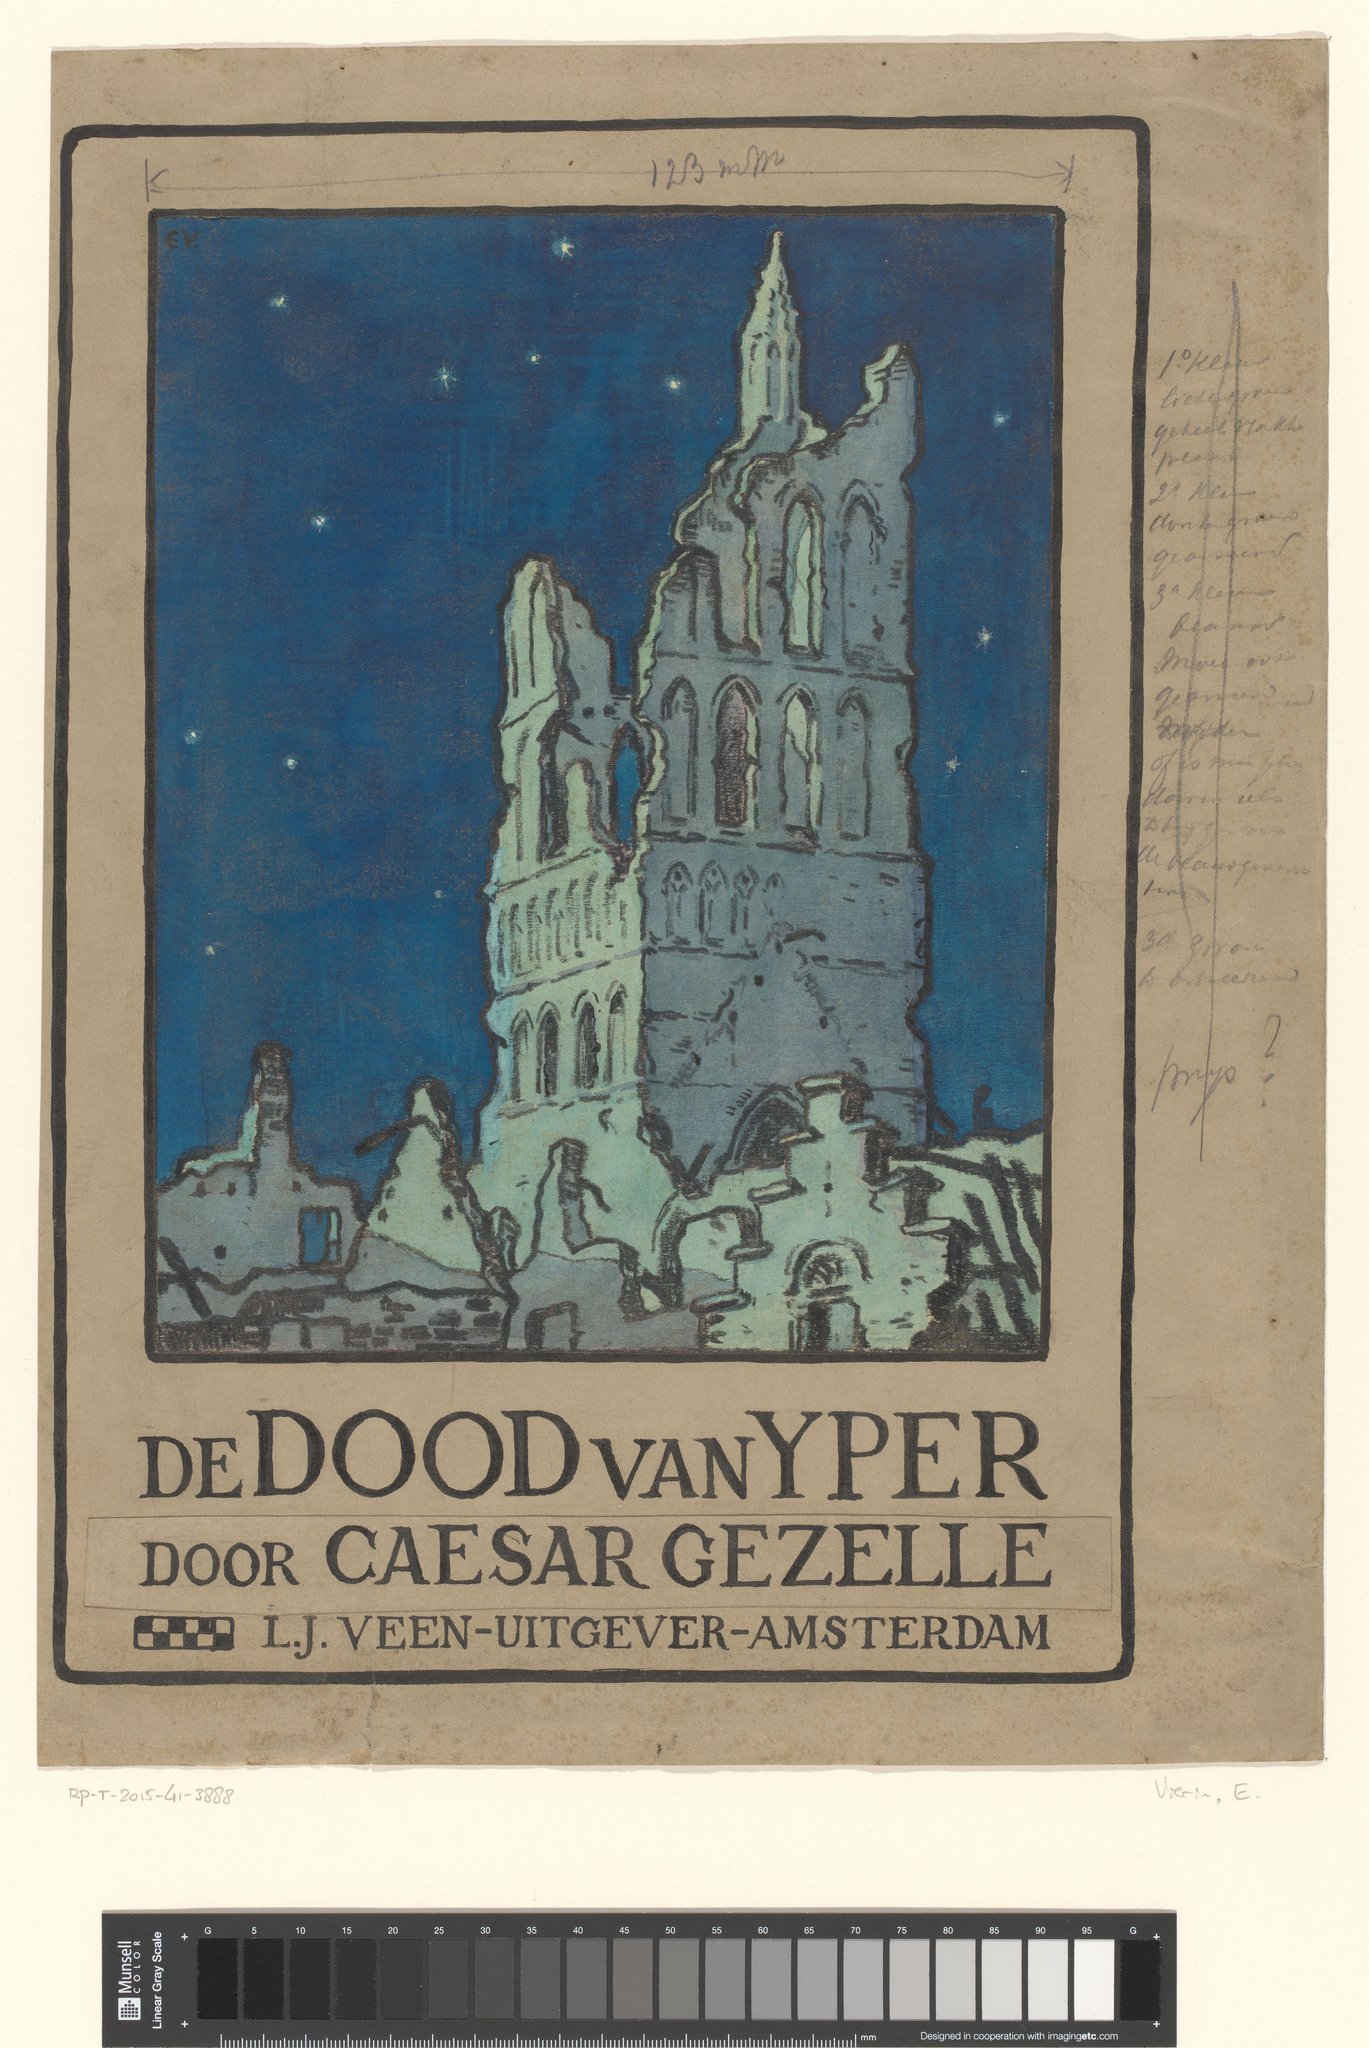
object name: study for binding design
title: Bandontwerp voor: Caesar Gezelle, De dood van Yper, 1916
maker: emmanuel viérin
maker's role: draughtsman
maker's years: 1869-1954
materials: chalk, paint, ink, paper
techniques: brush, pen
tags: ruin of church, monastery, etc., parts of church exterior and annexes: tower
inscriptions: collector's mark: Lugt 2228a, :, signature: ‘E.V.’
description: De afgebrokkelde toren van de Sint-Maartenskerk te Ieper bij nacht.